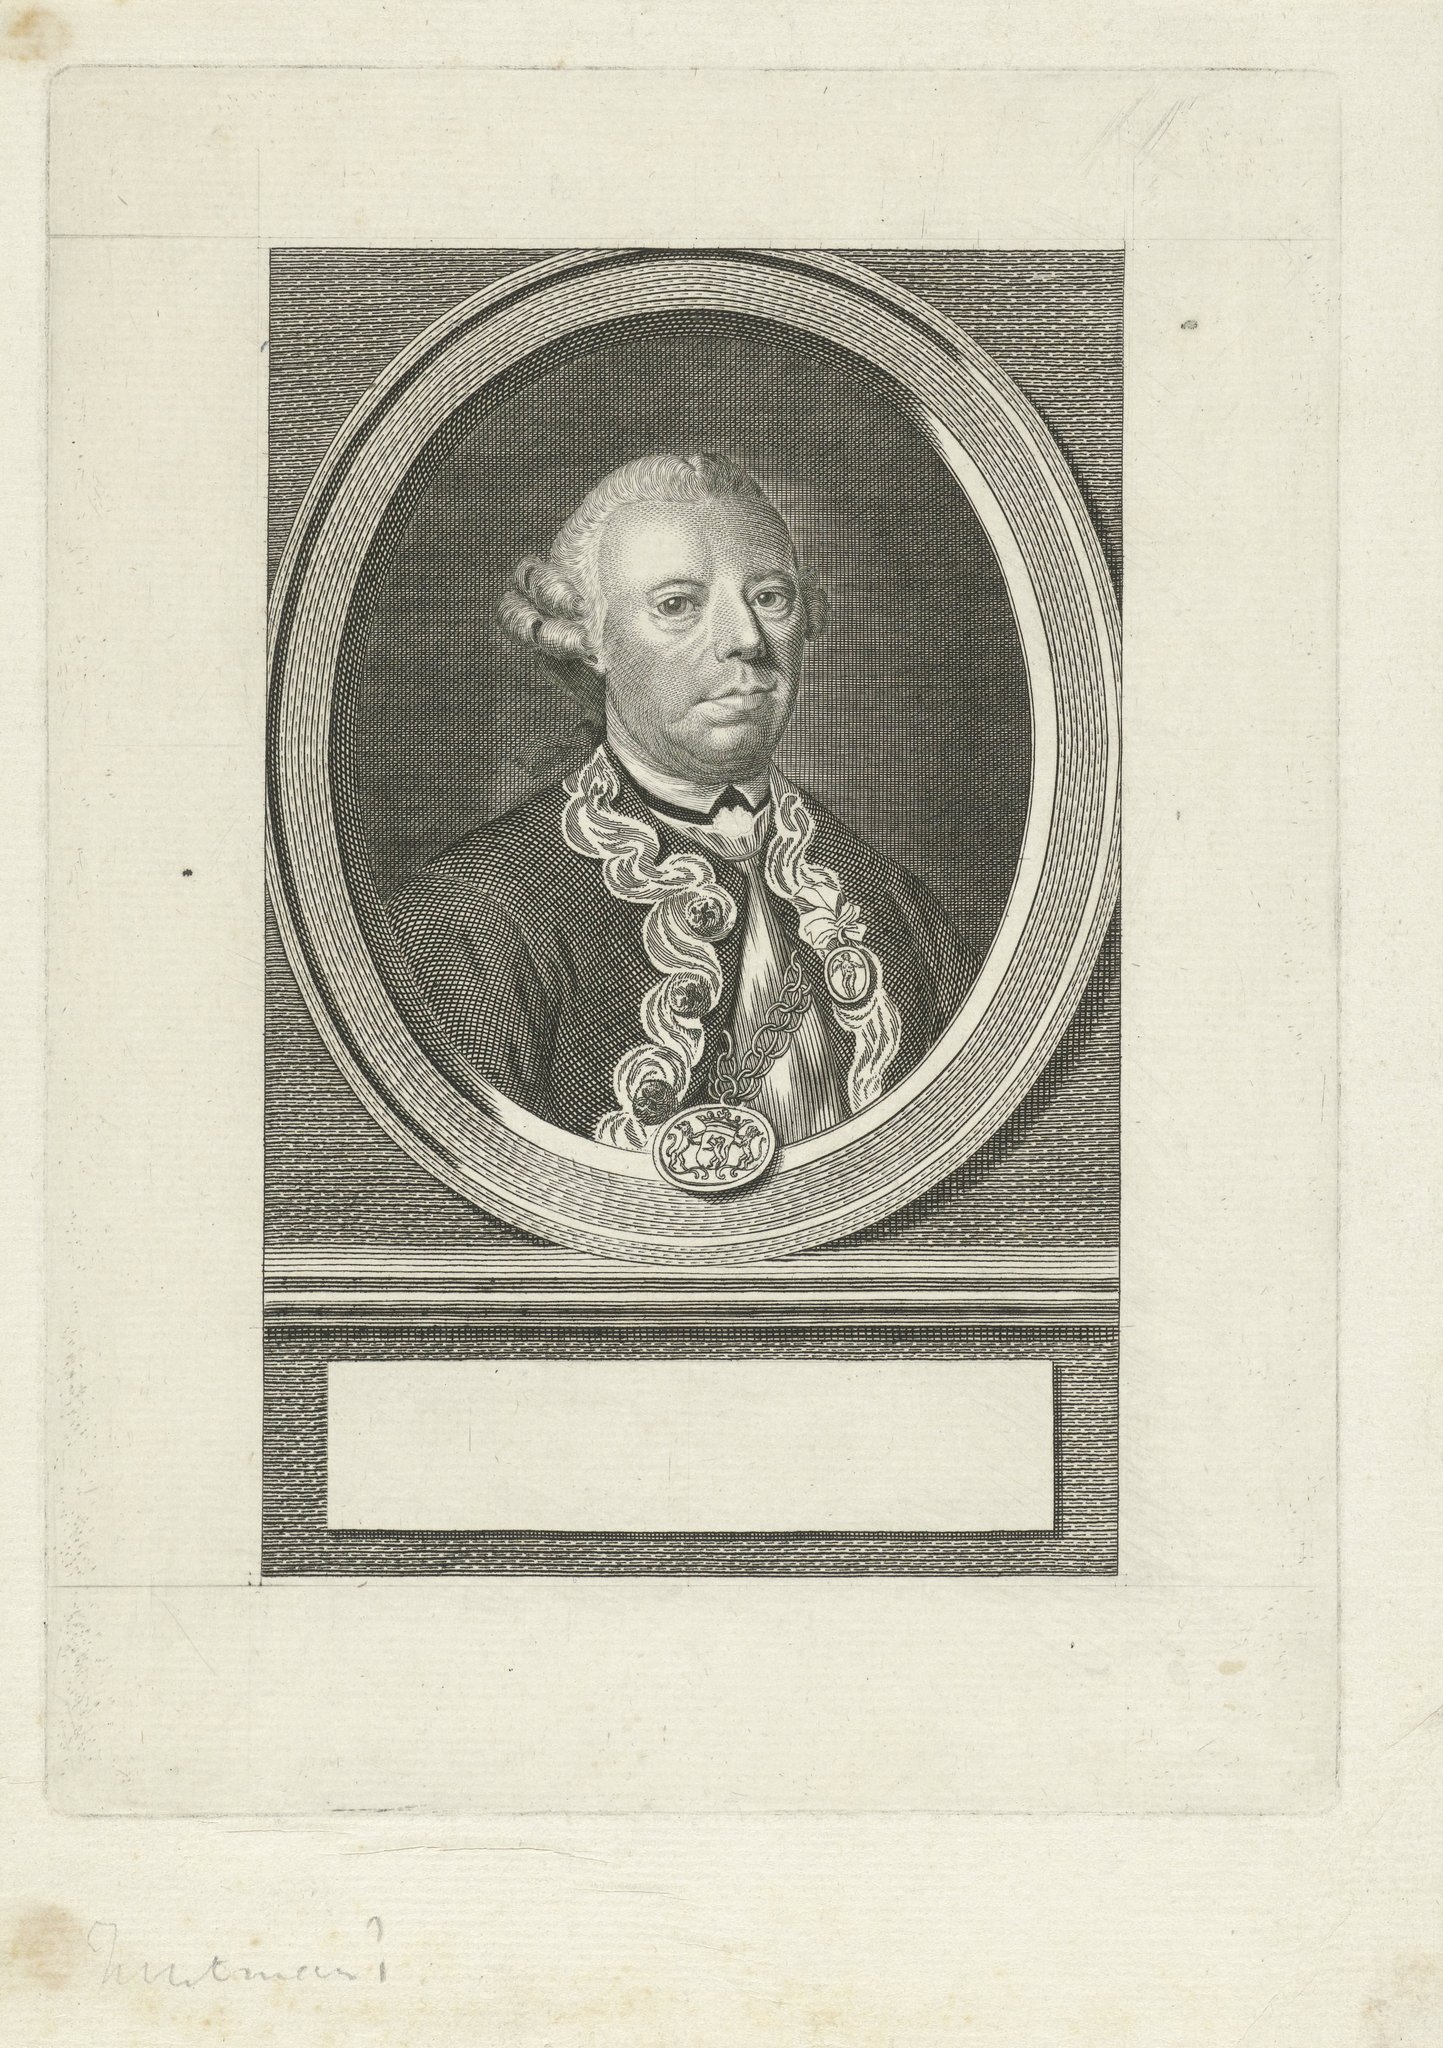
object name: print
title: Portret van Johan Arnold Zoutman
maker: pieter willem van megen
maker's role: print maker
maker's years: 1750-1785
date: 1775-1776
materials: paper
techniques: engraving, etching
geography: the hague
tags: the hague, johan arnold zoutman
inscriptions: collector's mark: Lugt 240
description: Latere staat prent waarschijnlijk uit: Nomsz., Johannes. Mengelwerk. Amsterdam: s.n., 1776, dl. 3.